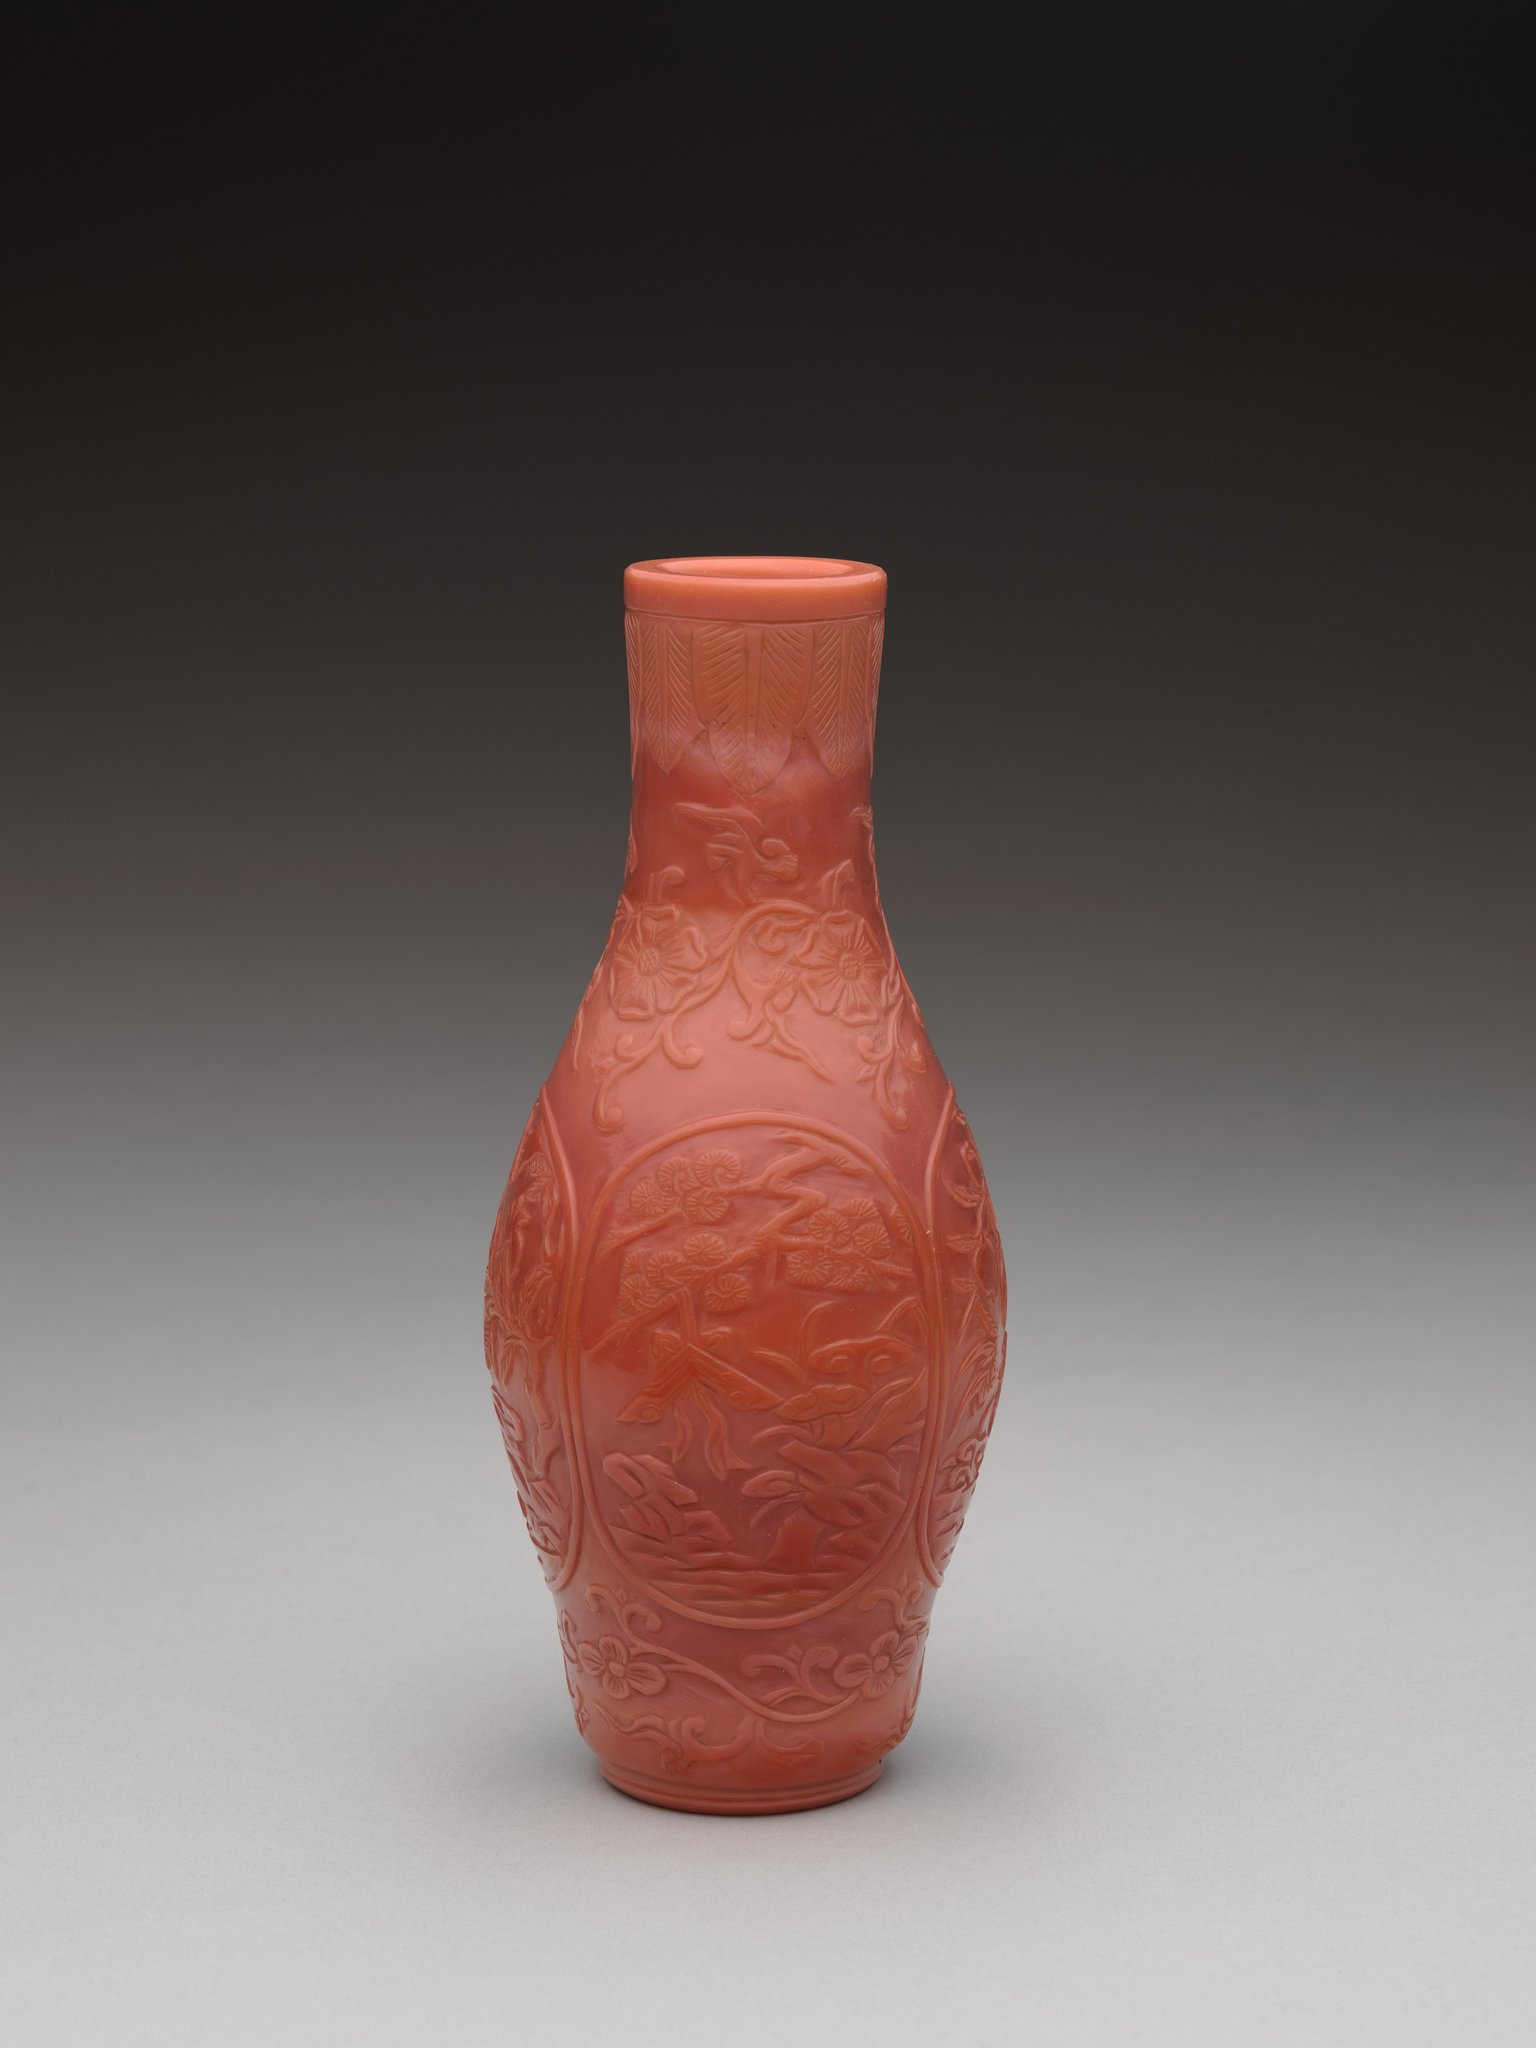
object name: vase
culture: chinese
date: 1801-1833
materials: glass